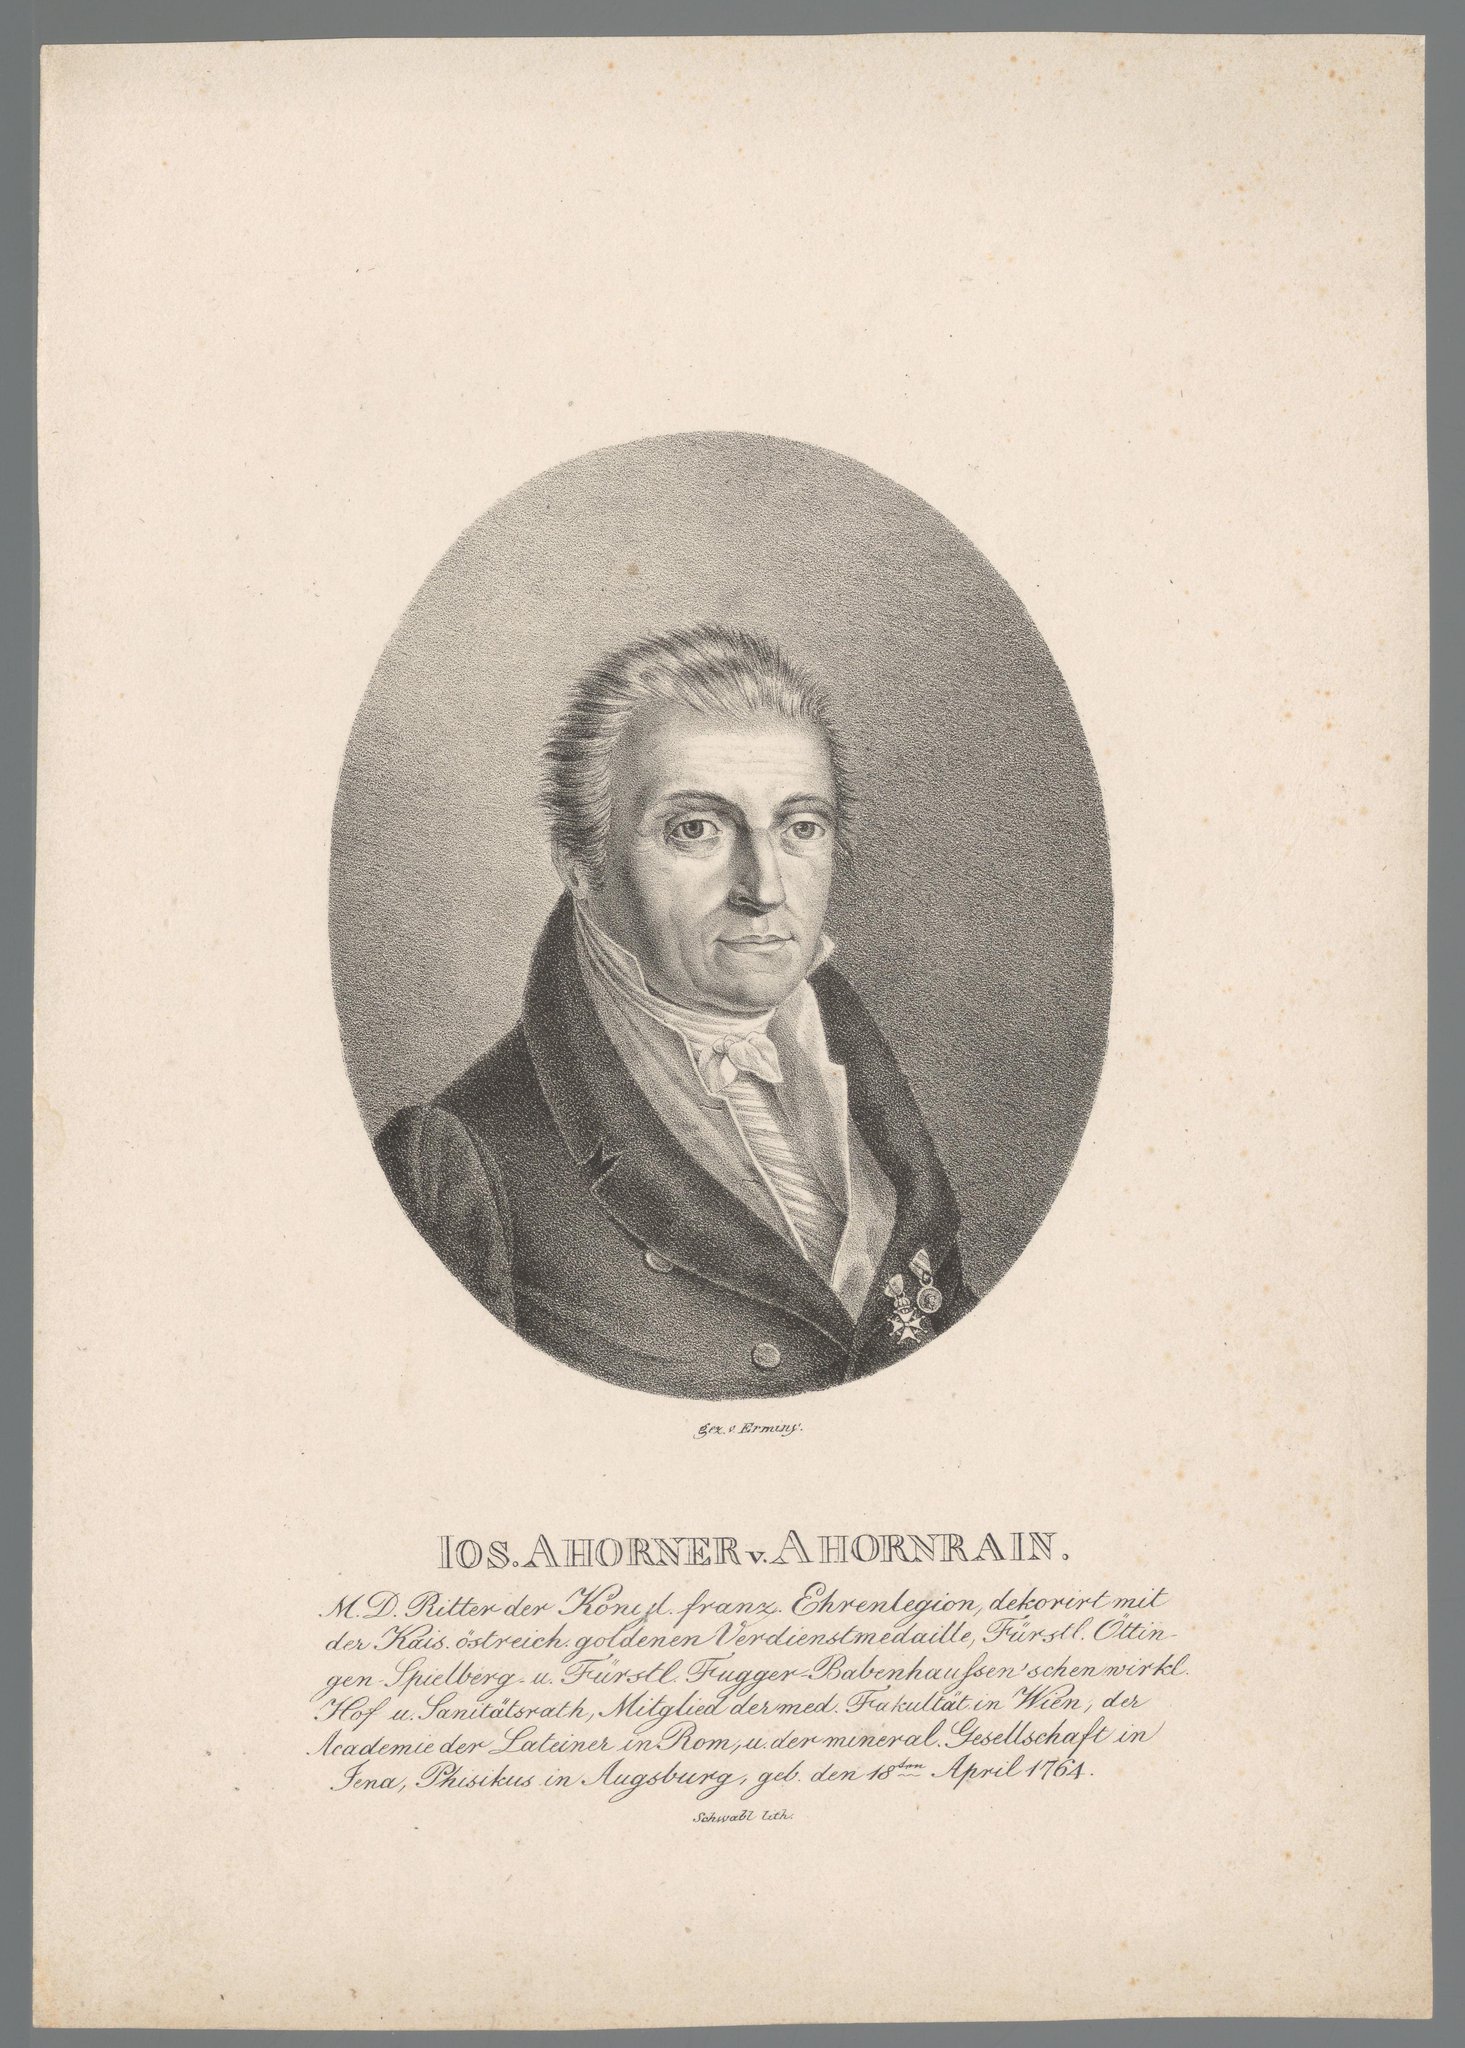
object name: print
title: Jos. Ahorner v. Ahornrain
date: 1820-1850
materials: paper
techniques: lithograph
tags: adult man, historical persons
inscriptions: collector's mark: Lugt 2228